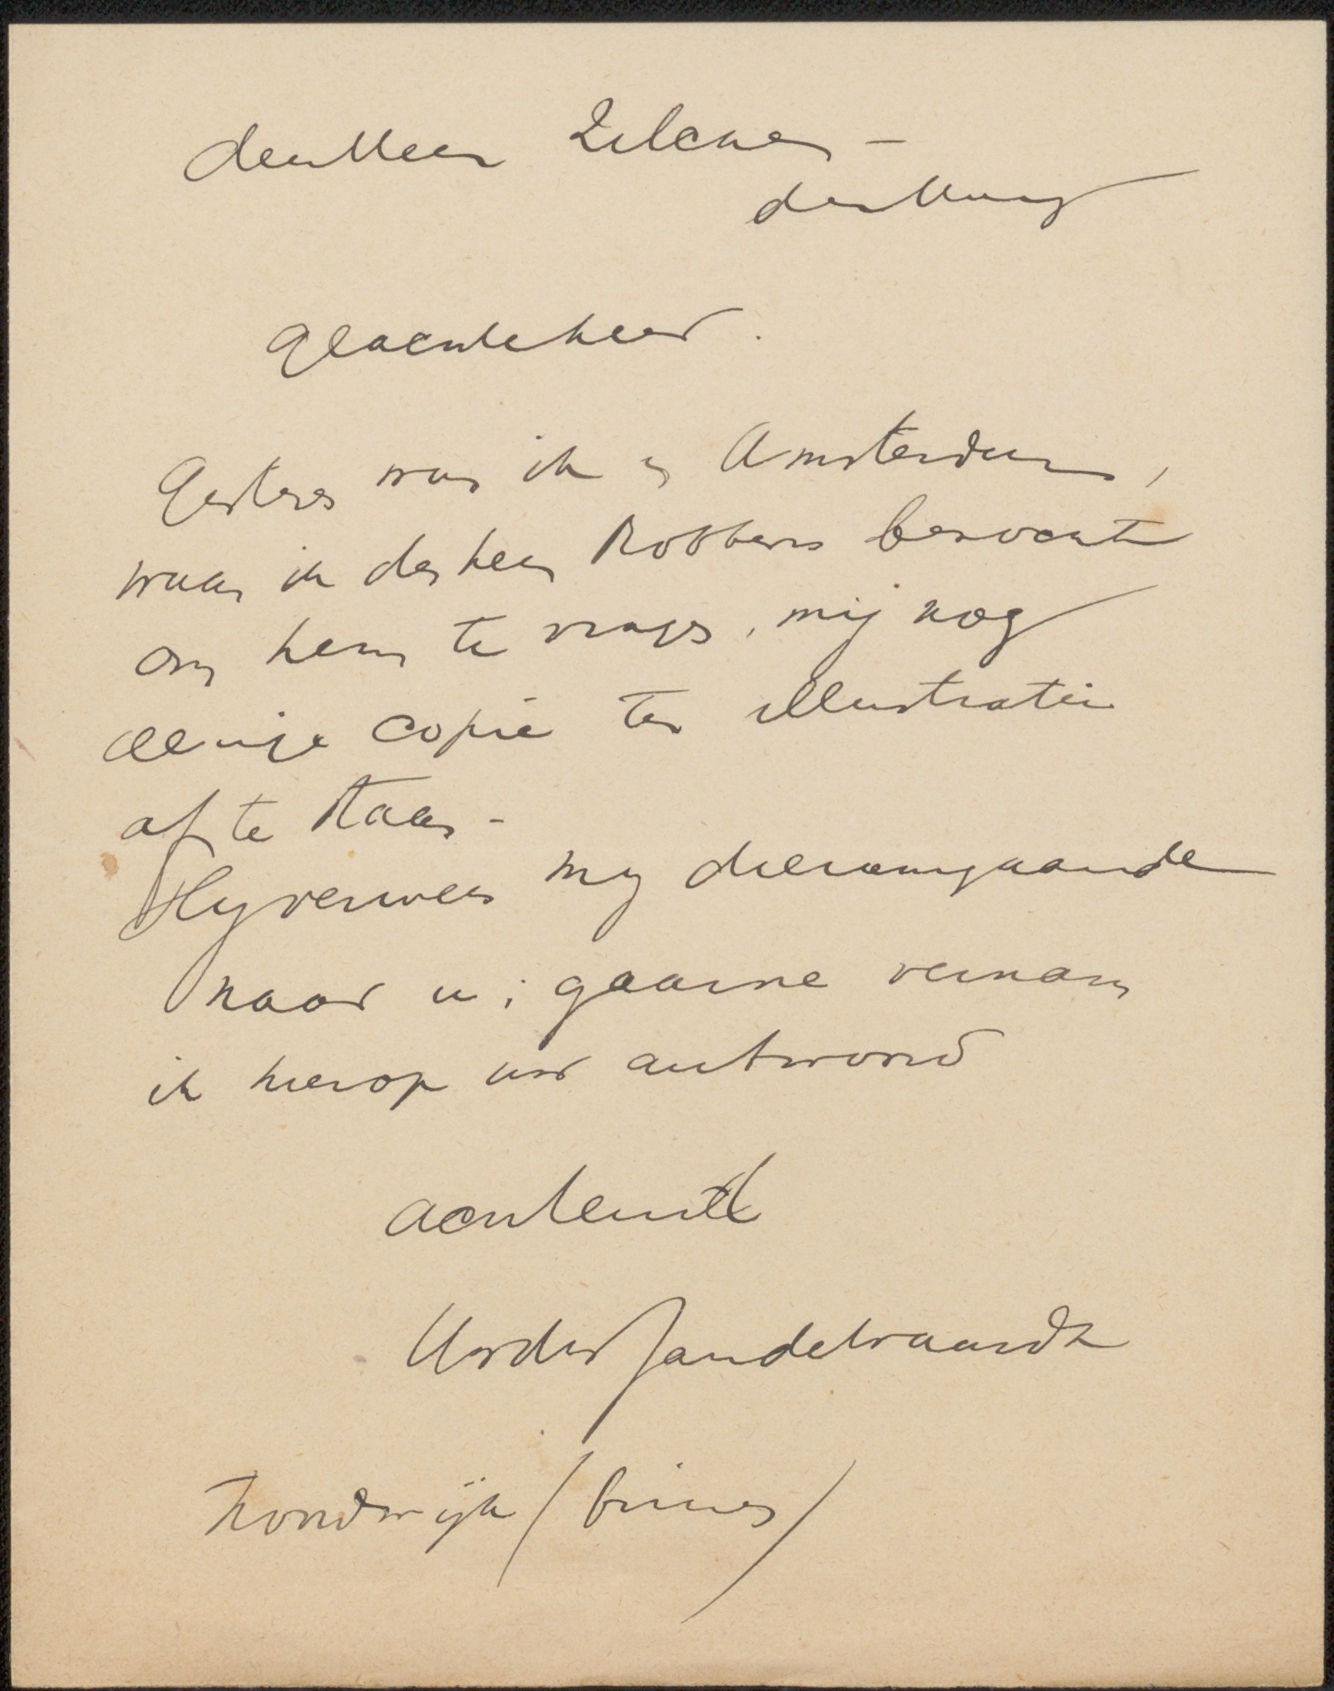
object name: letter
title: Brief aan Philip Zilcken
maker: jan de waardt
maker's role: draughtsman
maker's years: 1871-1909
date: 1881-1909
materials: ink, paper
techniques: pen, writing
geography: noordwijk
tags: the hague, painter, philip zilcken, amsterdam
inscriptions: collector's mark: ‘RPK’